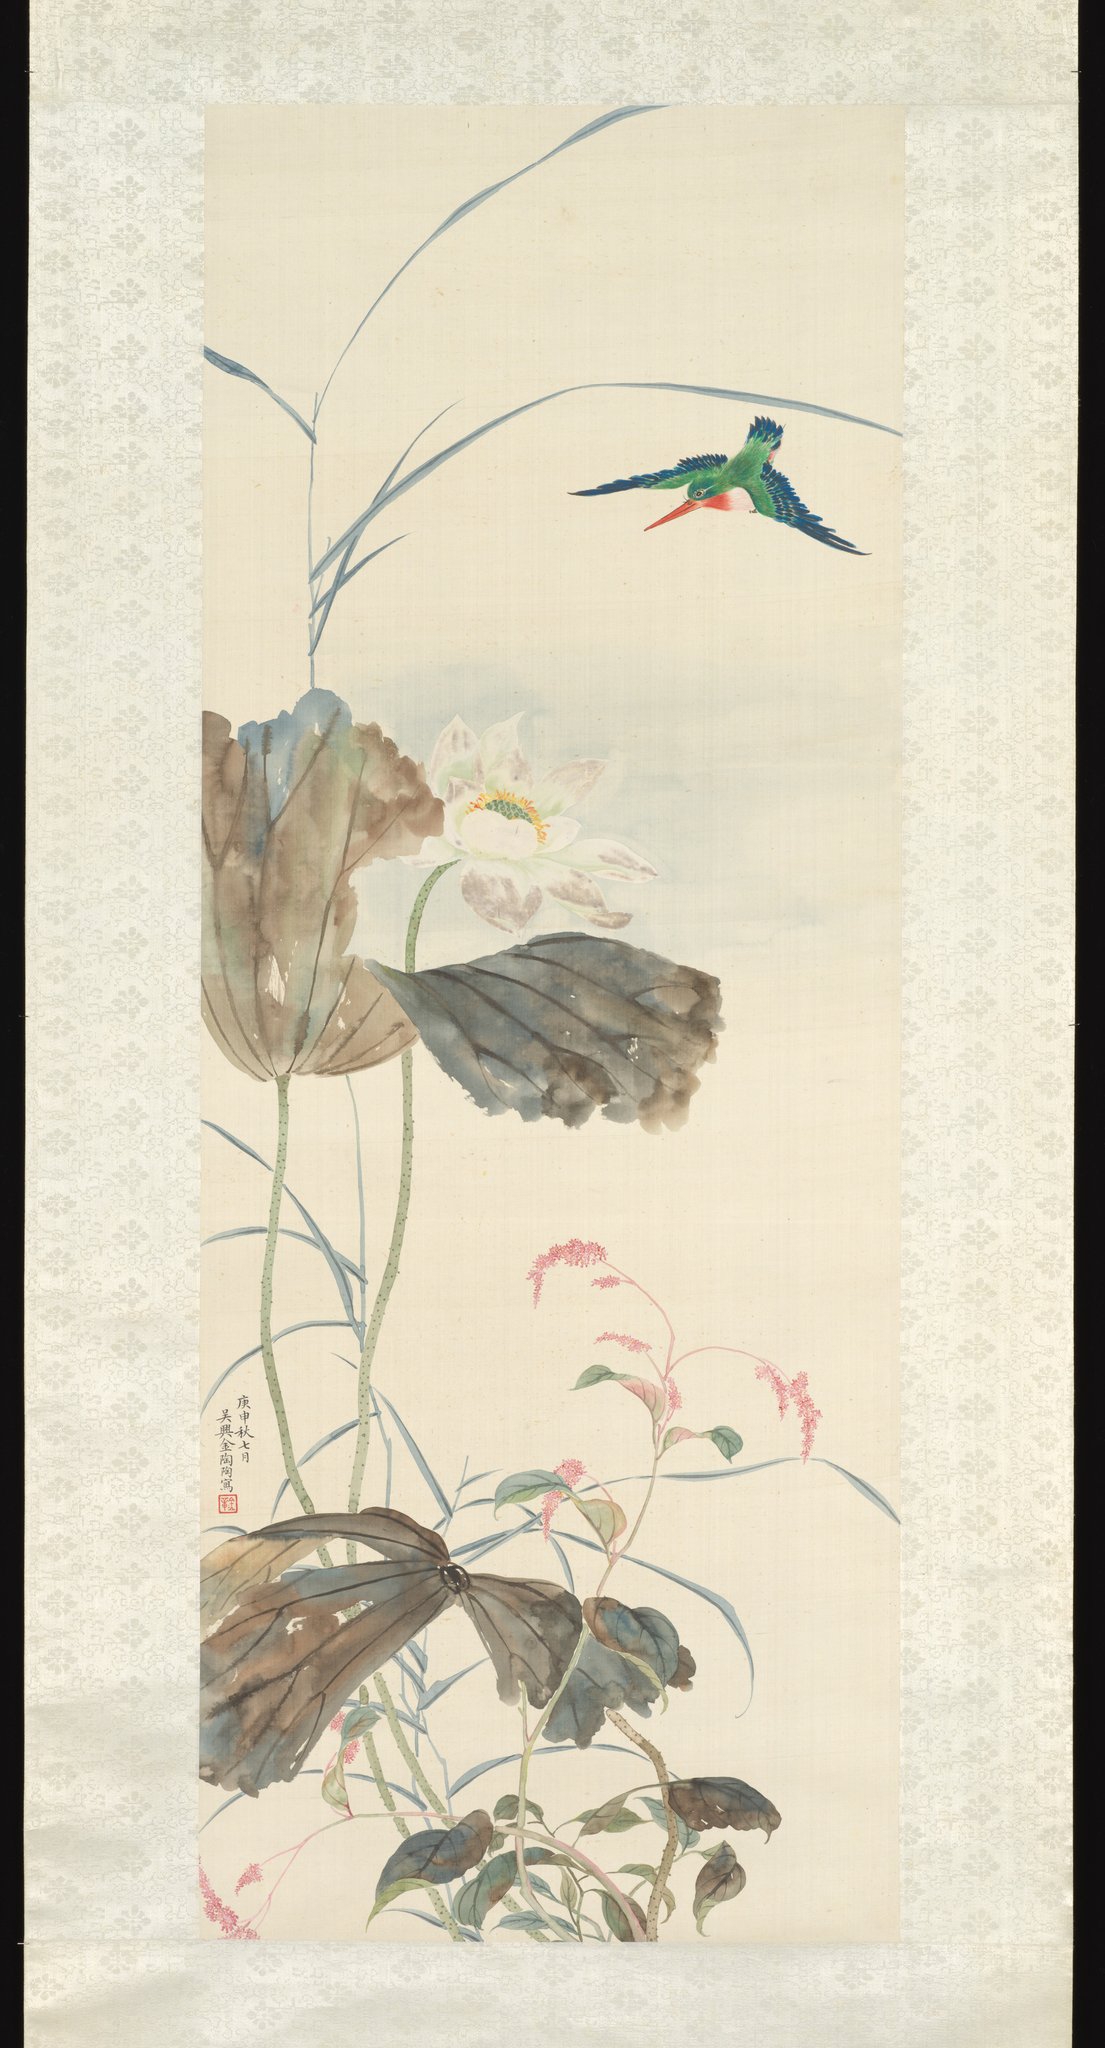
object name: hanging scroll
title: Kingfisher and Lotus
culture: chinese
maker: jin zhang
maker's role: artist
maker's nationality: chinese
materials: ink, silk